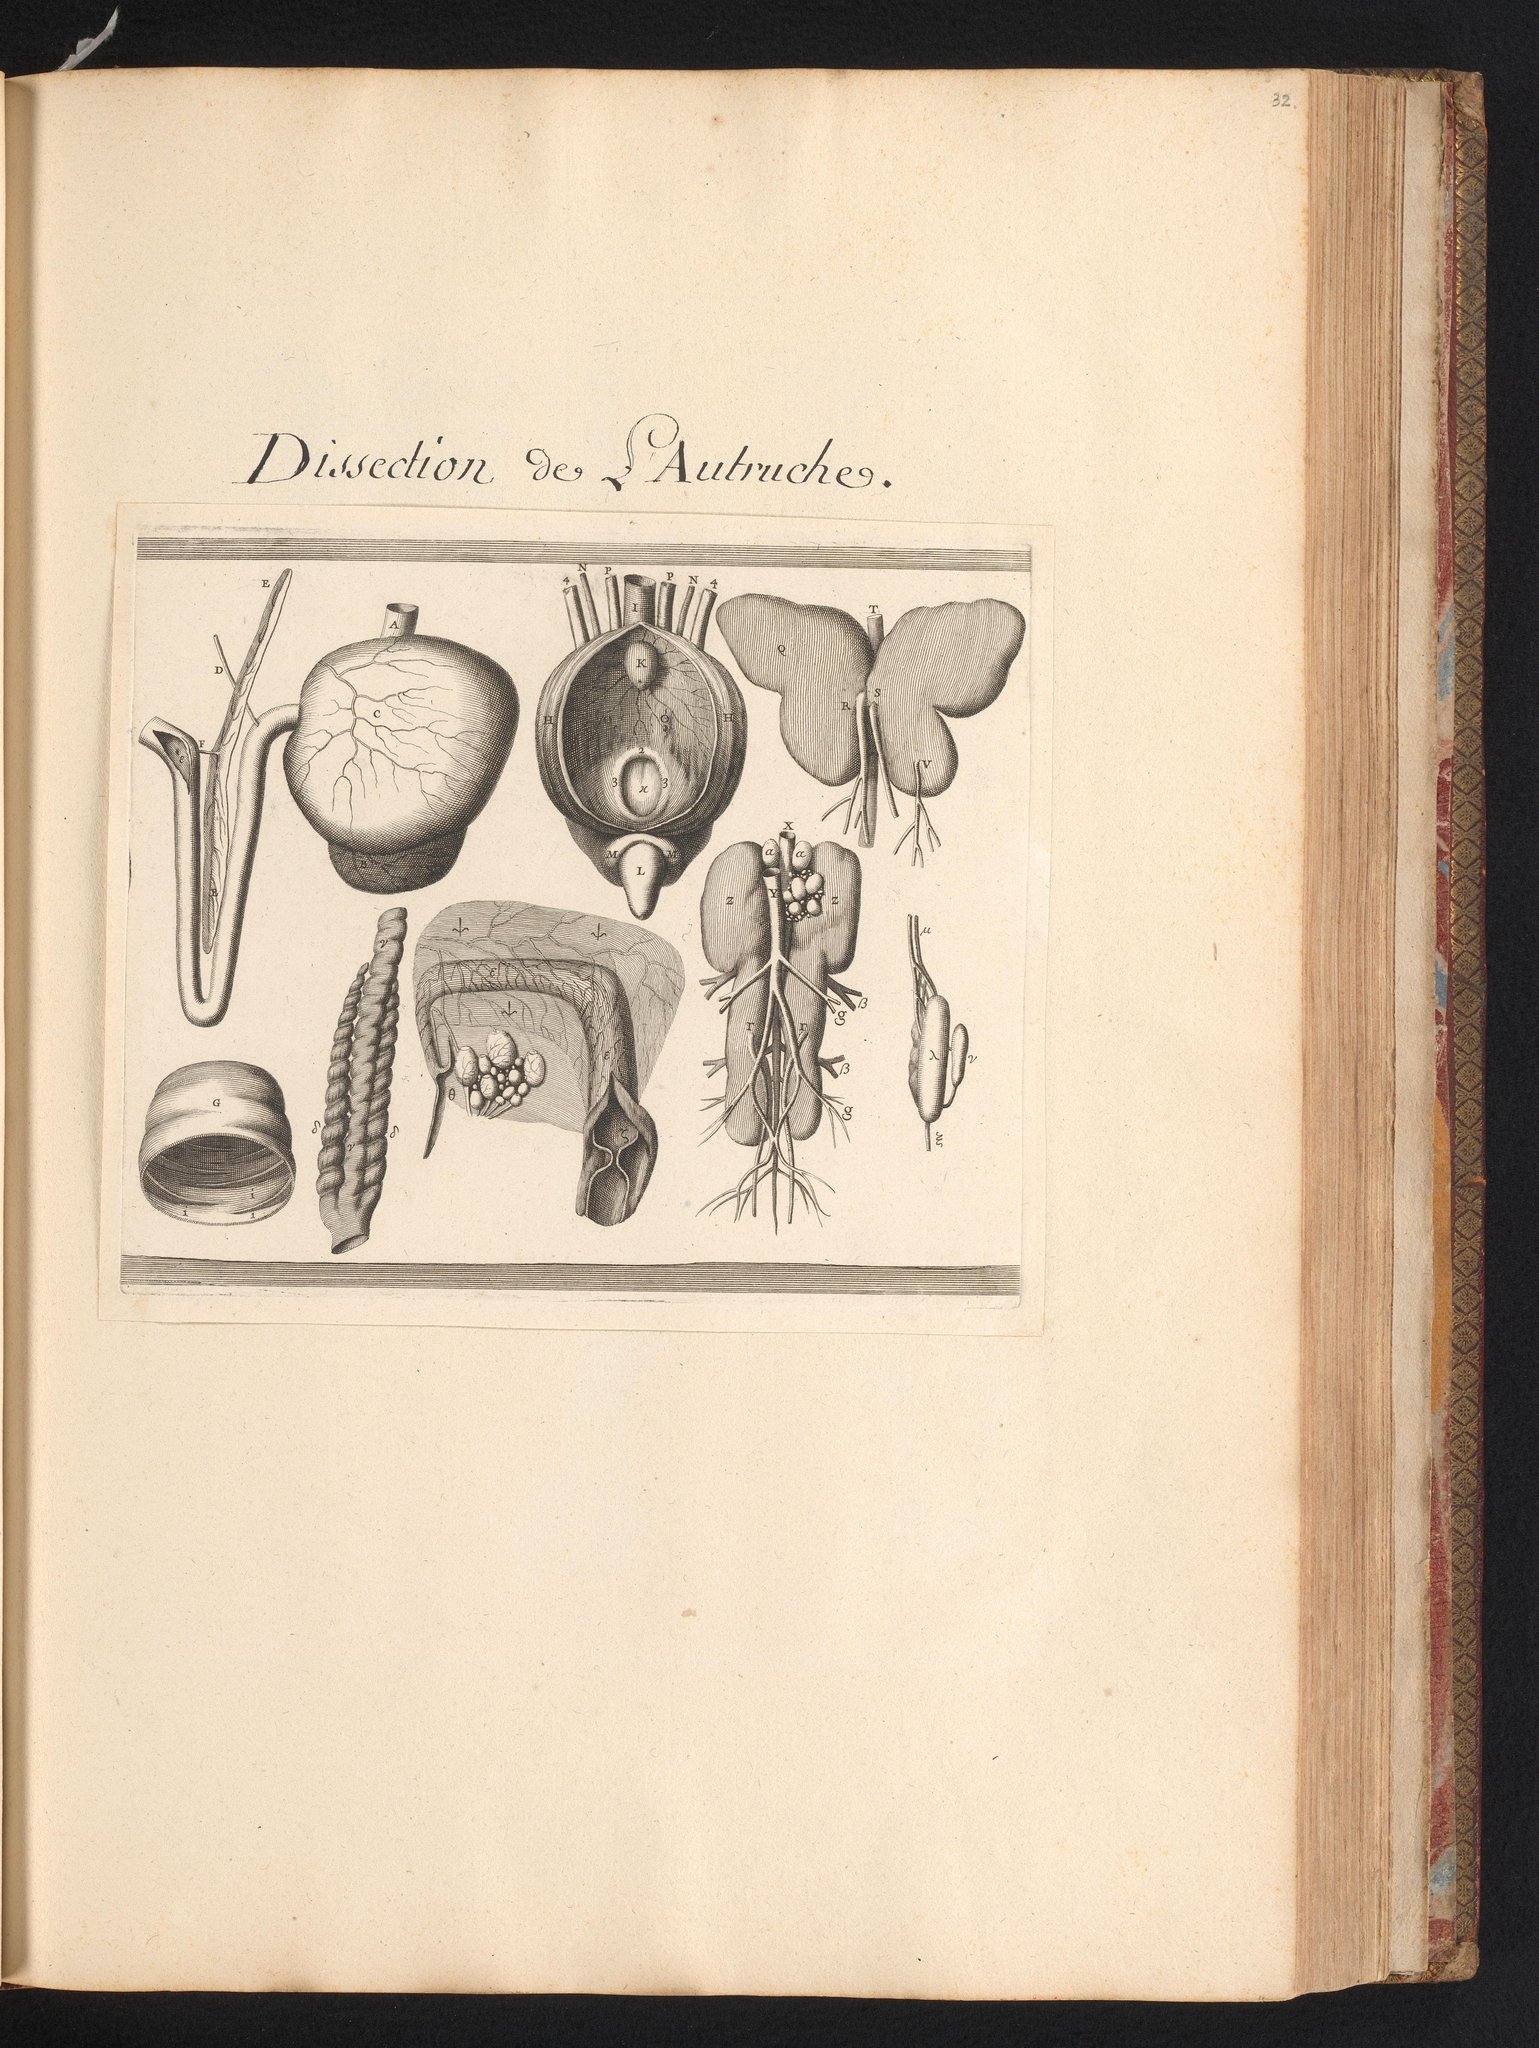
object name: album leaf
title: Anatomie van een struisvogel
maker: sébastien leclerc (i)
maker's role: print maker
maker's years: 1637-1714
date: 1676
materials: ink, paper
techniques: engraving, etching, pen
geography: paris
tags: dissection, walker and runner birds: ostrich, animals (+ anatomy of animals), walker and runner birds: ostrich (+ anatomy of animals)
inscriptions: inscription: ‘Dissection de L'Autriche.’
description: Prent uit: Perrault, Claude. Mémoires pour servir à l'histoire naturelle des animaux. Dressez par M. Perrault de l'Académie Royale des Sciences (...). Parijs: Imprimerie Royale, 1676.